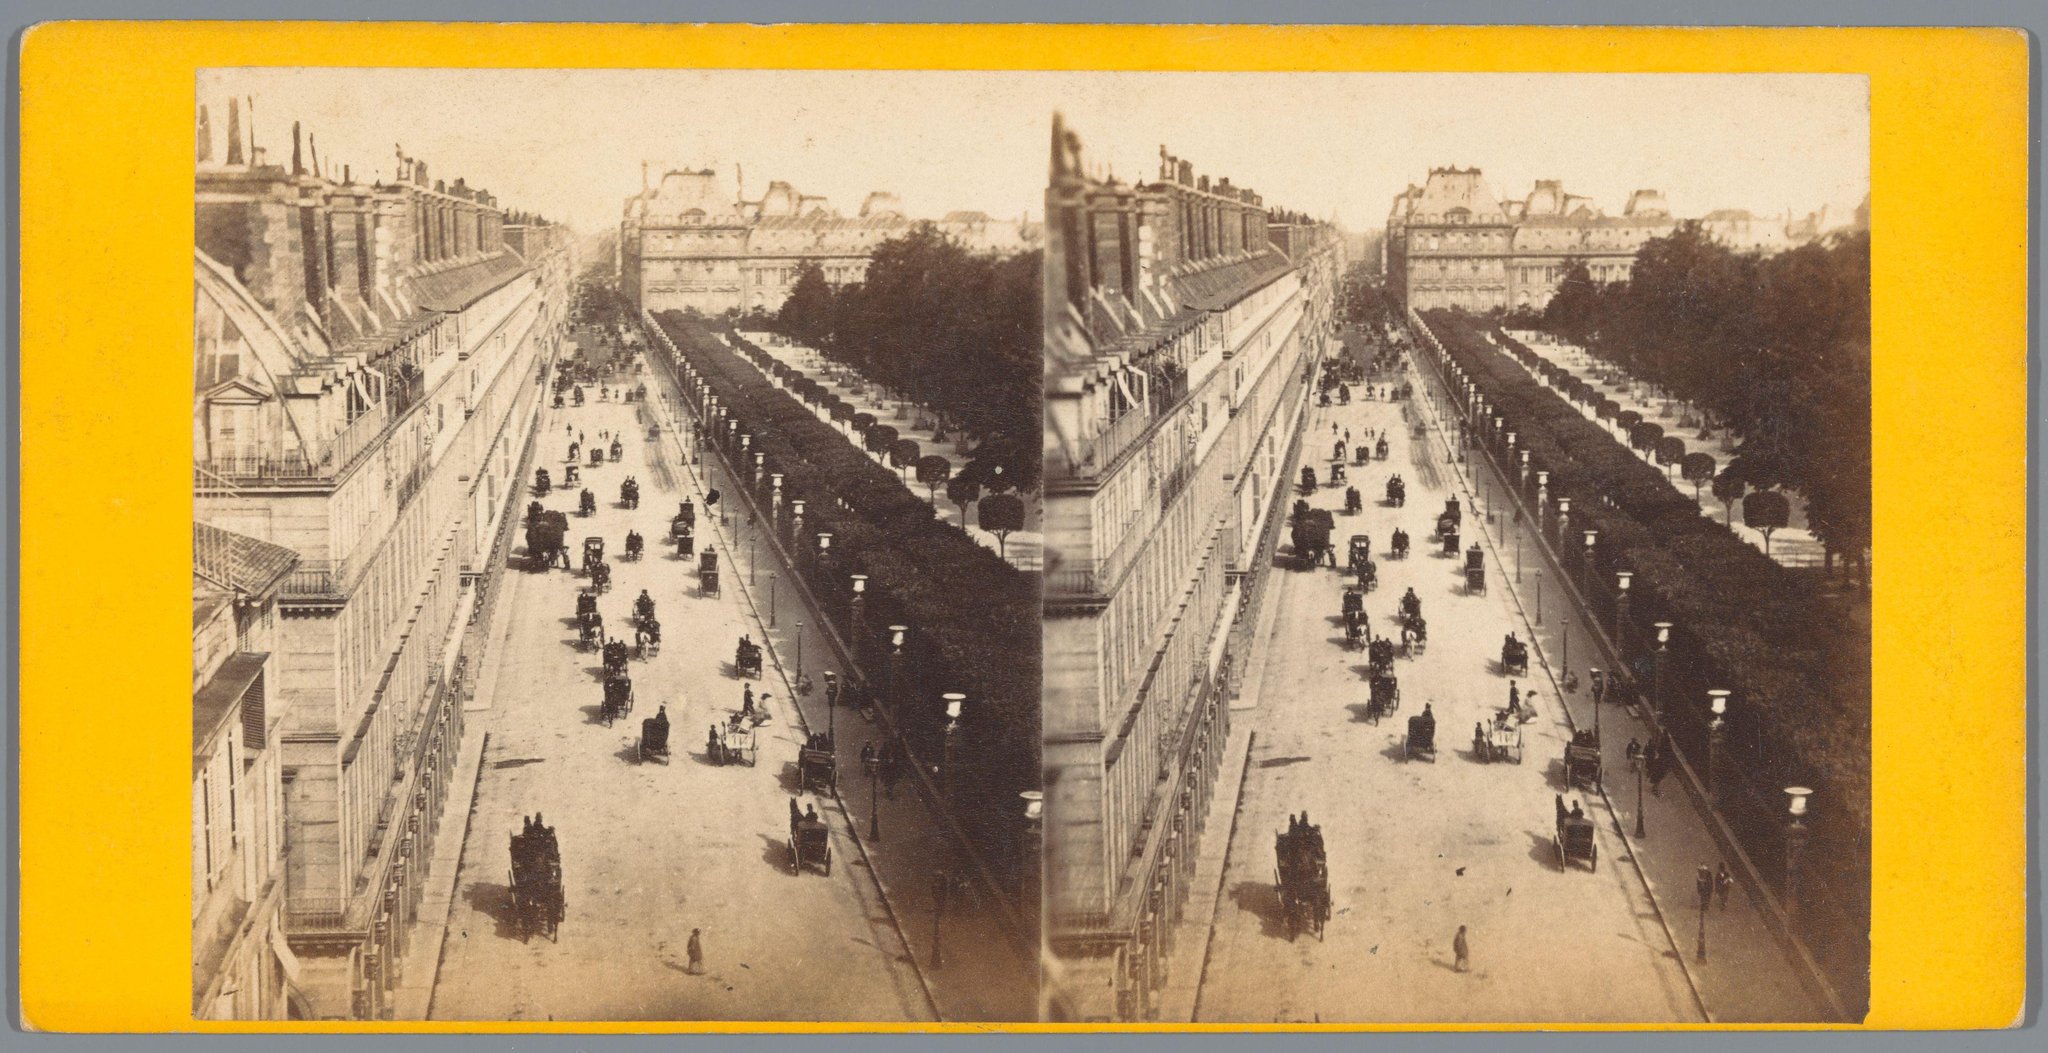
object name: stereograph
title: Paris Instantané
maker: Anonymous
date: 1850-1880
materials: cardboard, photographic support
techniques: albumen print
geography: paris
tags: animal traction, animal-drawn vehicle (carriage etc.), street